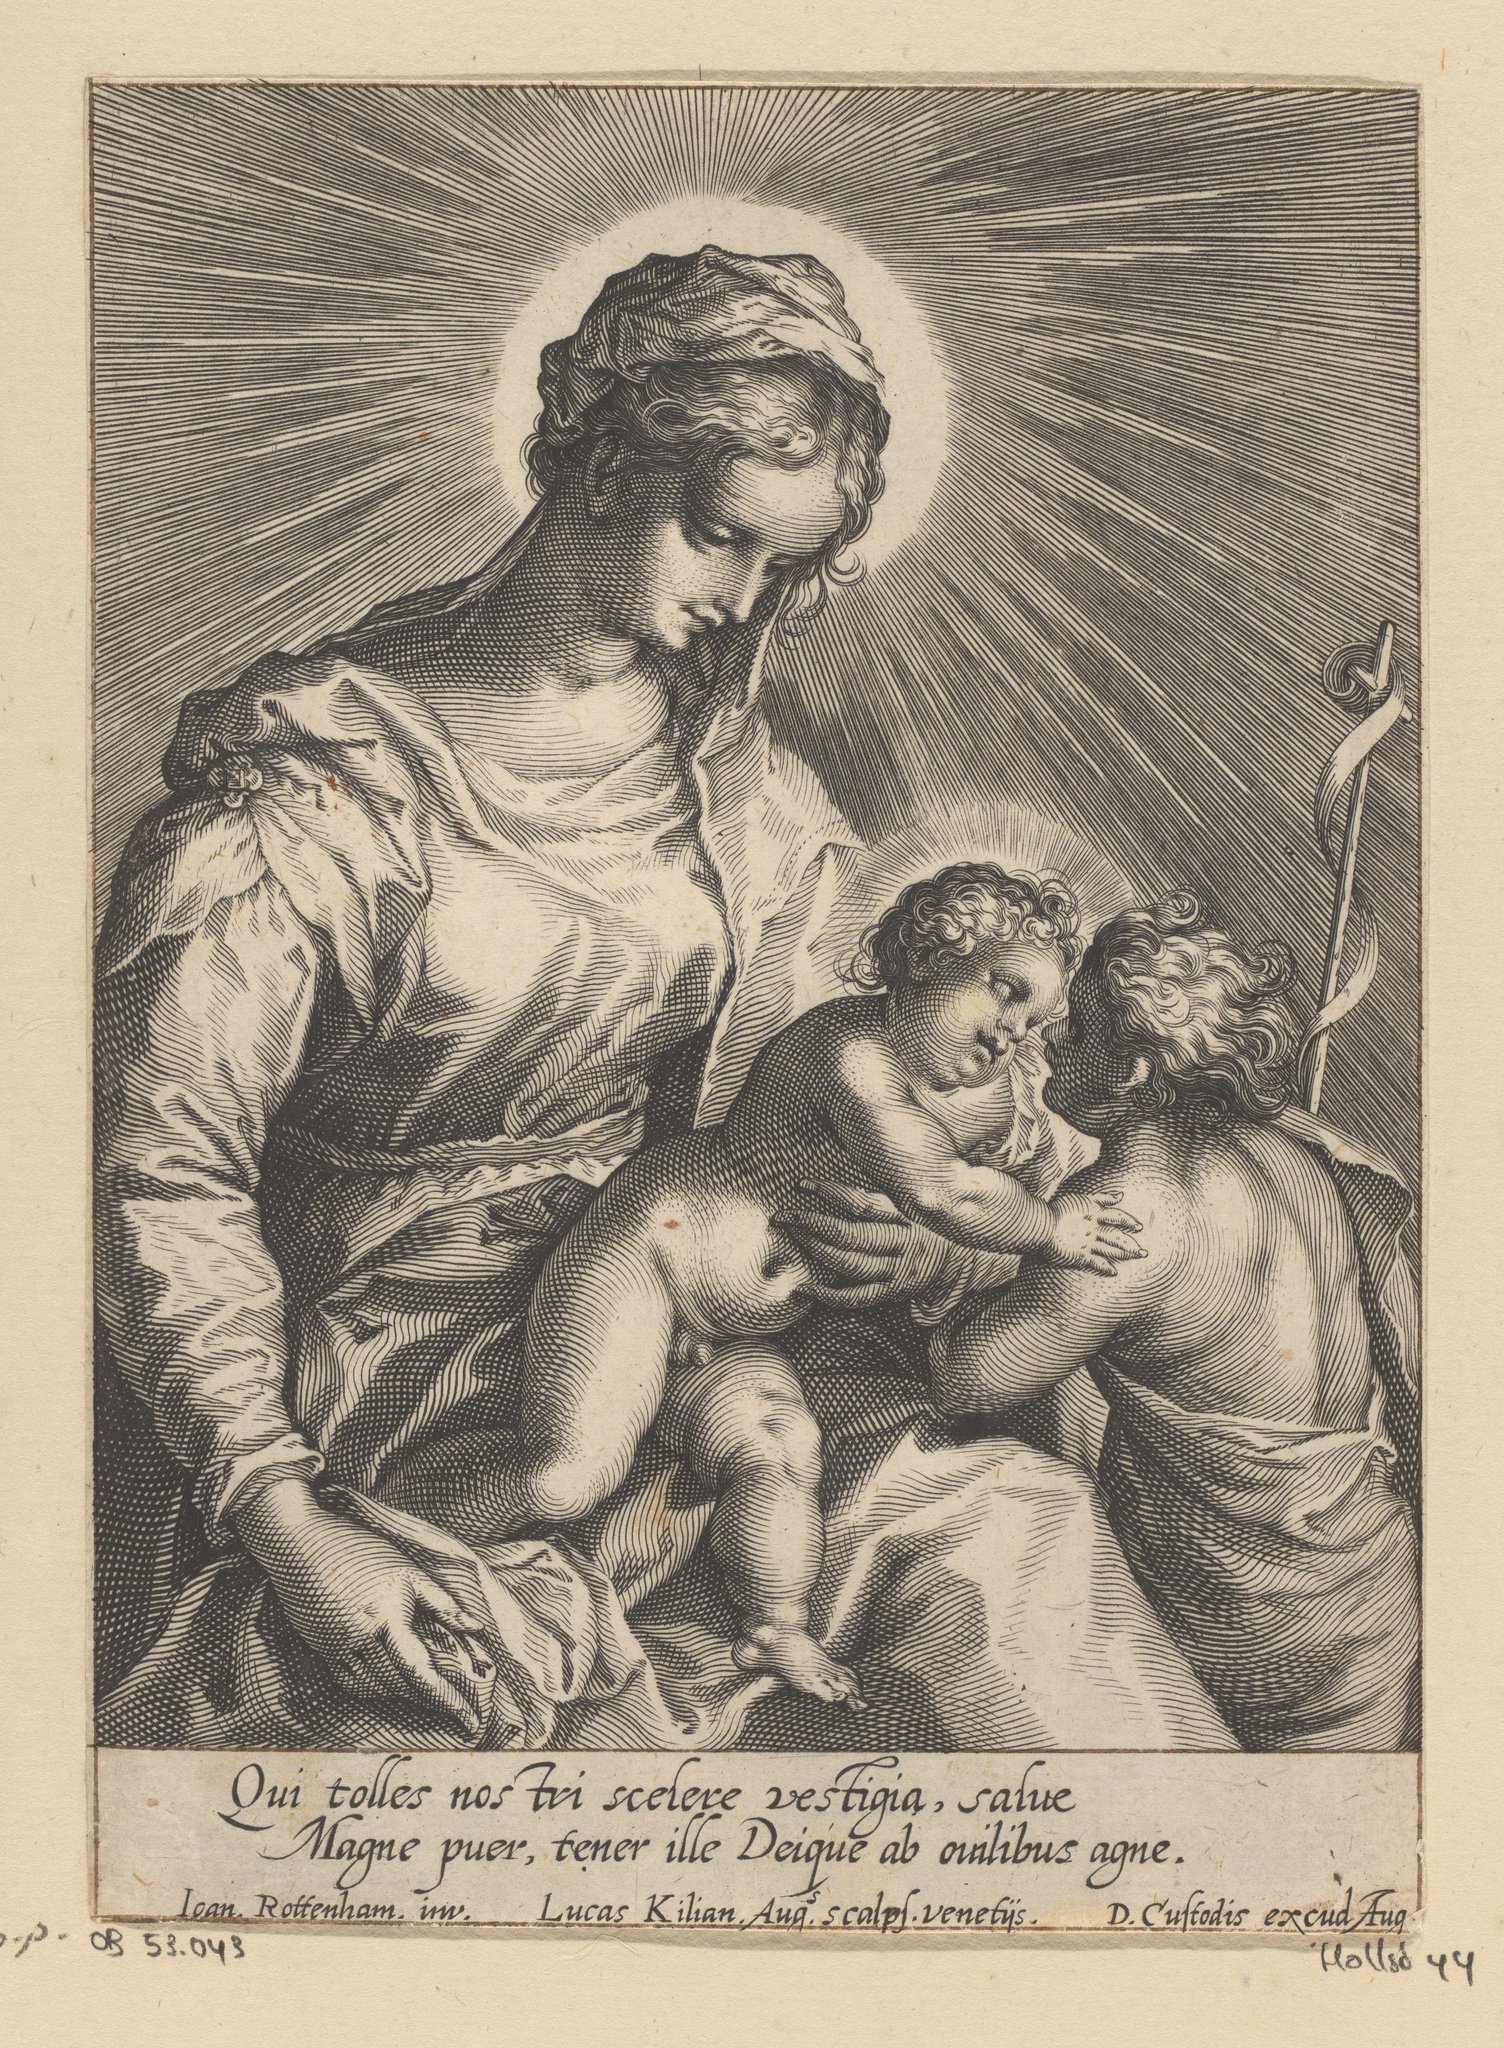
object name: print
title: Maria met kind en Johannes de Doper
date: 1589-1615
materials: paper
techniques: engraving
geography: augsburg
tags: mary and the christ-child with john the baptist (as child)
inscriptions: collector's mark: Lugt 240